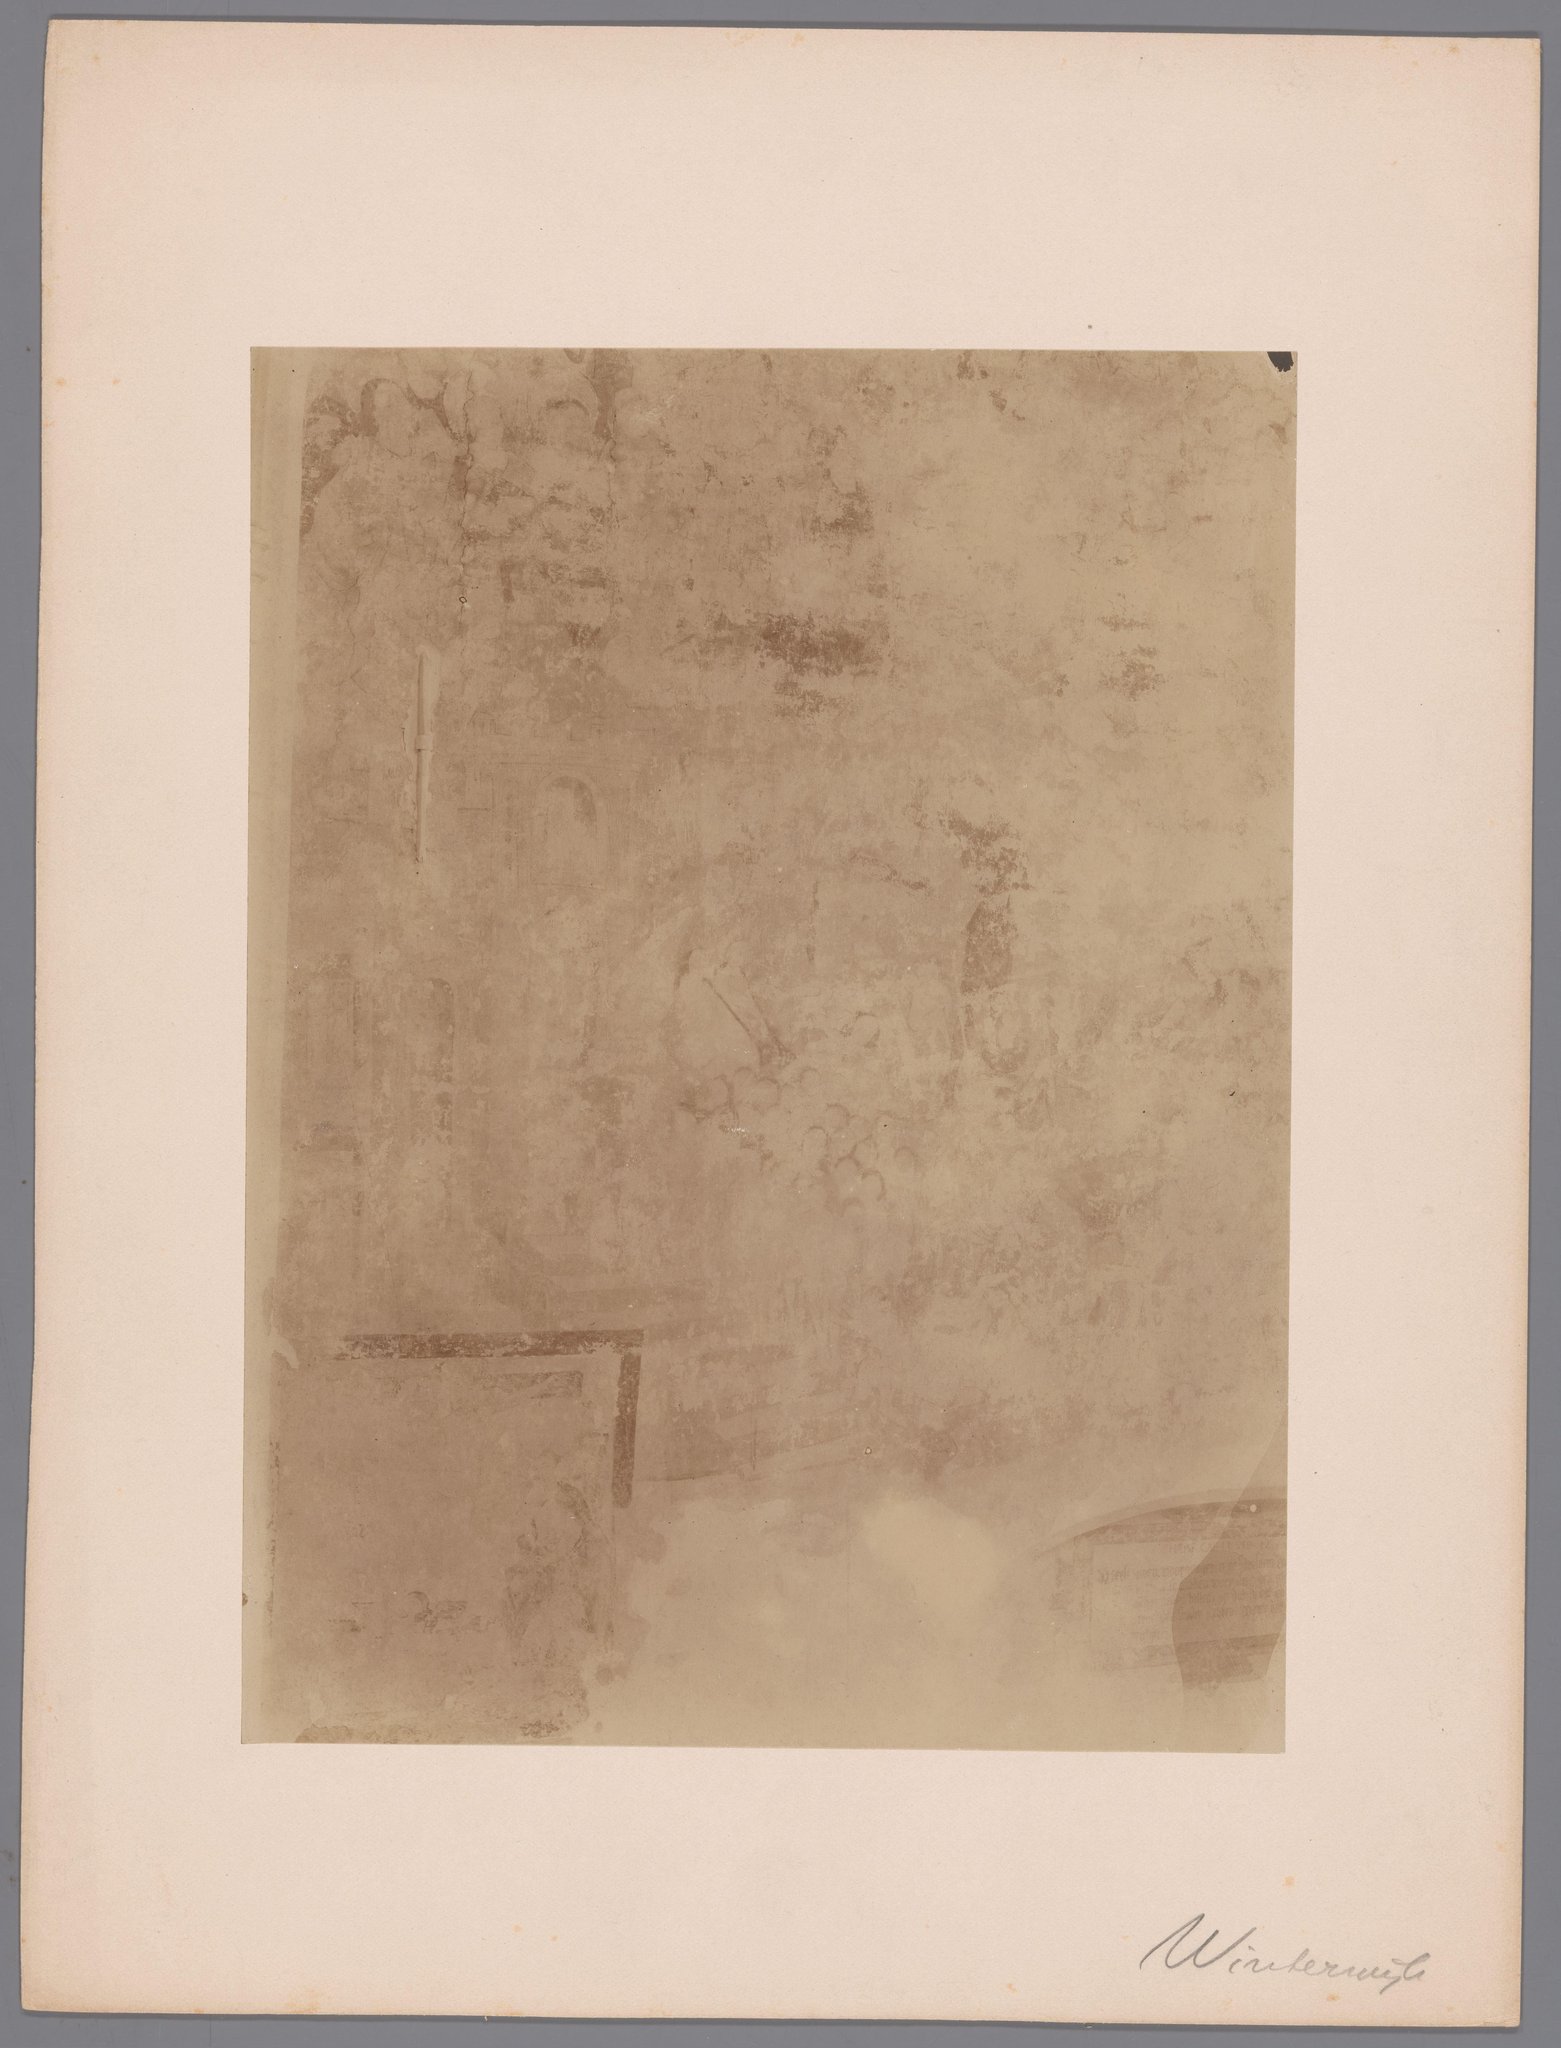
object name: photograph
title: Muurschildering in de Jacobskerk te Winterswijk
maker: anoniem (monumentenzorg)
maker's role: fotograaf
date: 1895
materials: cardboard, photographic support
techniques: collodion silver print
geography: winterswijk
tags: interior of church, picture, painting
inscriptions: annotation: ‘Winterswijk (G.)/ Ontdekte muurschildering in de kerk der N.H. gem - detail/ juni 1895’, annotation: ‘Winterswijk’